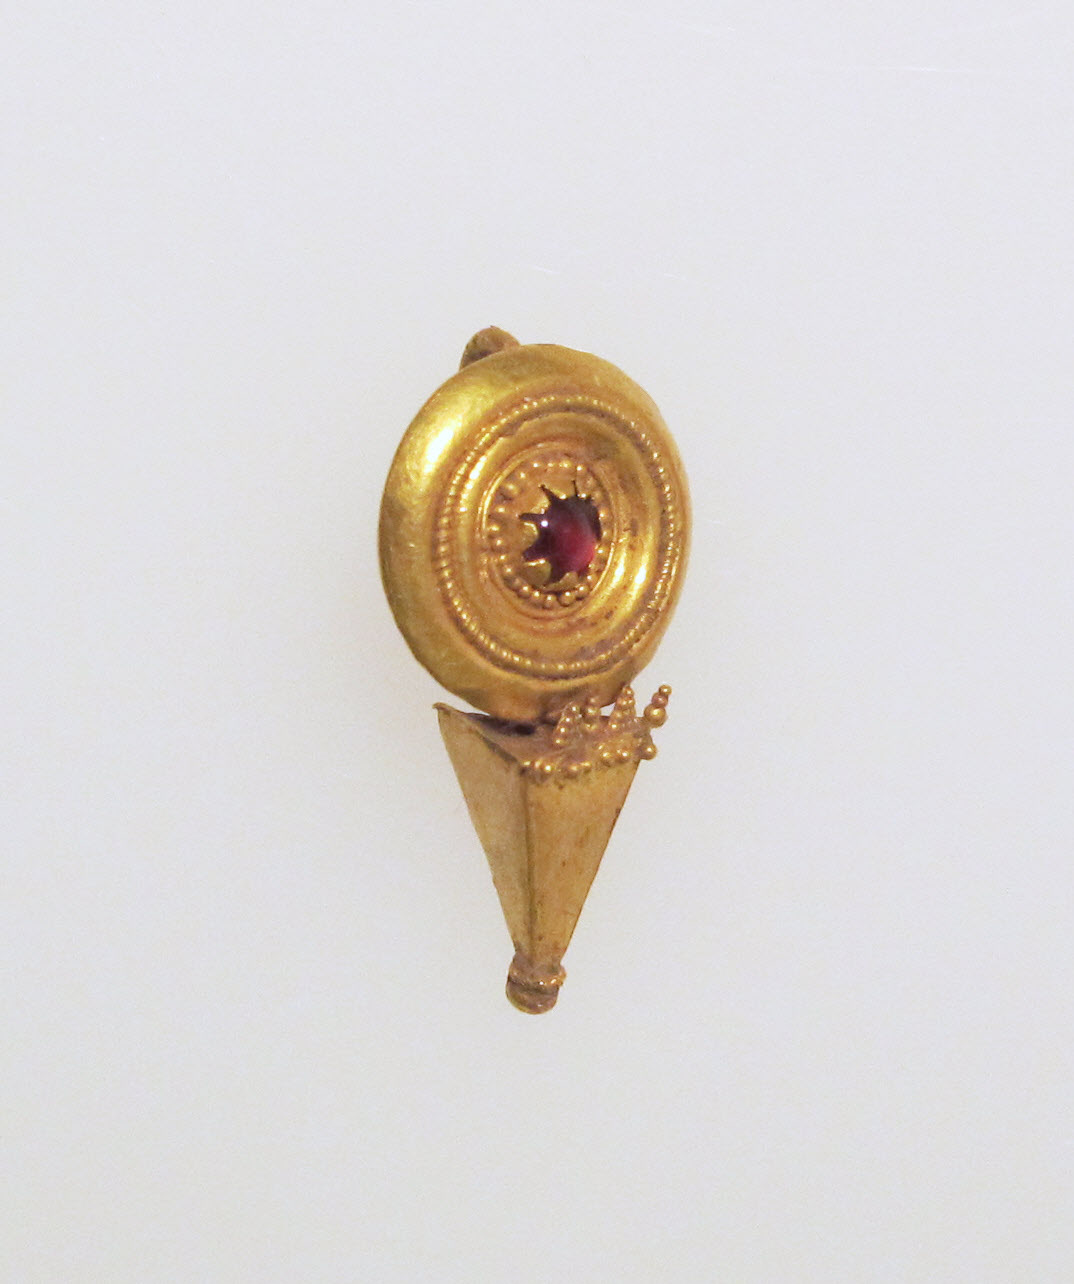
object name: earring with disc and pyramid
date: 7000 BCE-330 CE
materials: gemstone, gold